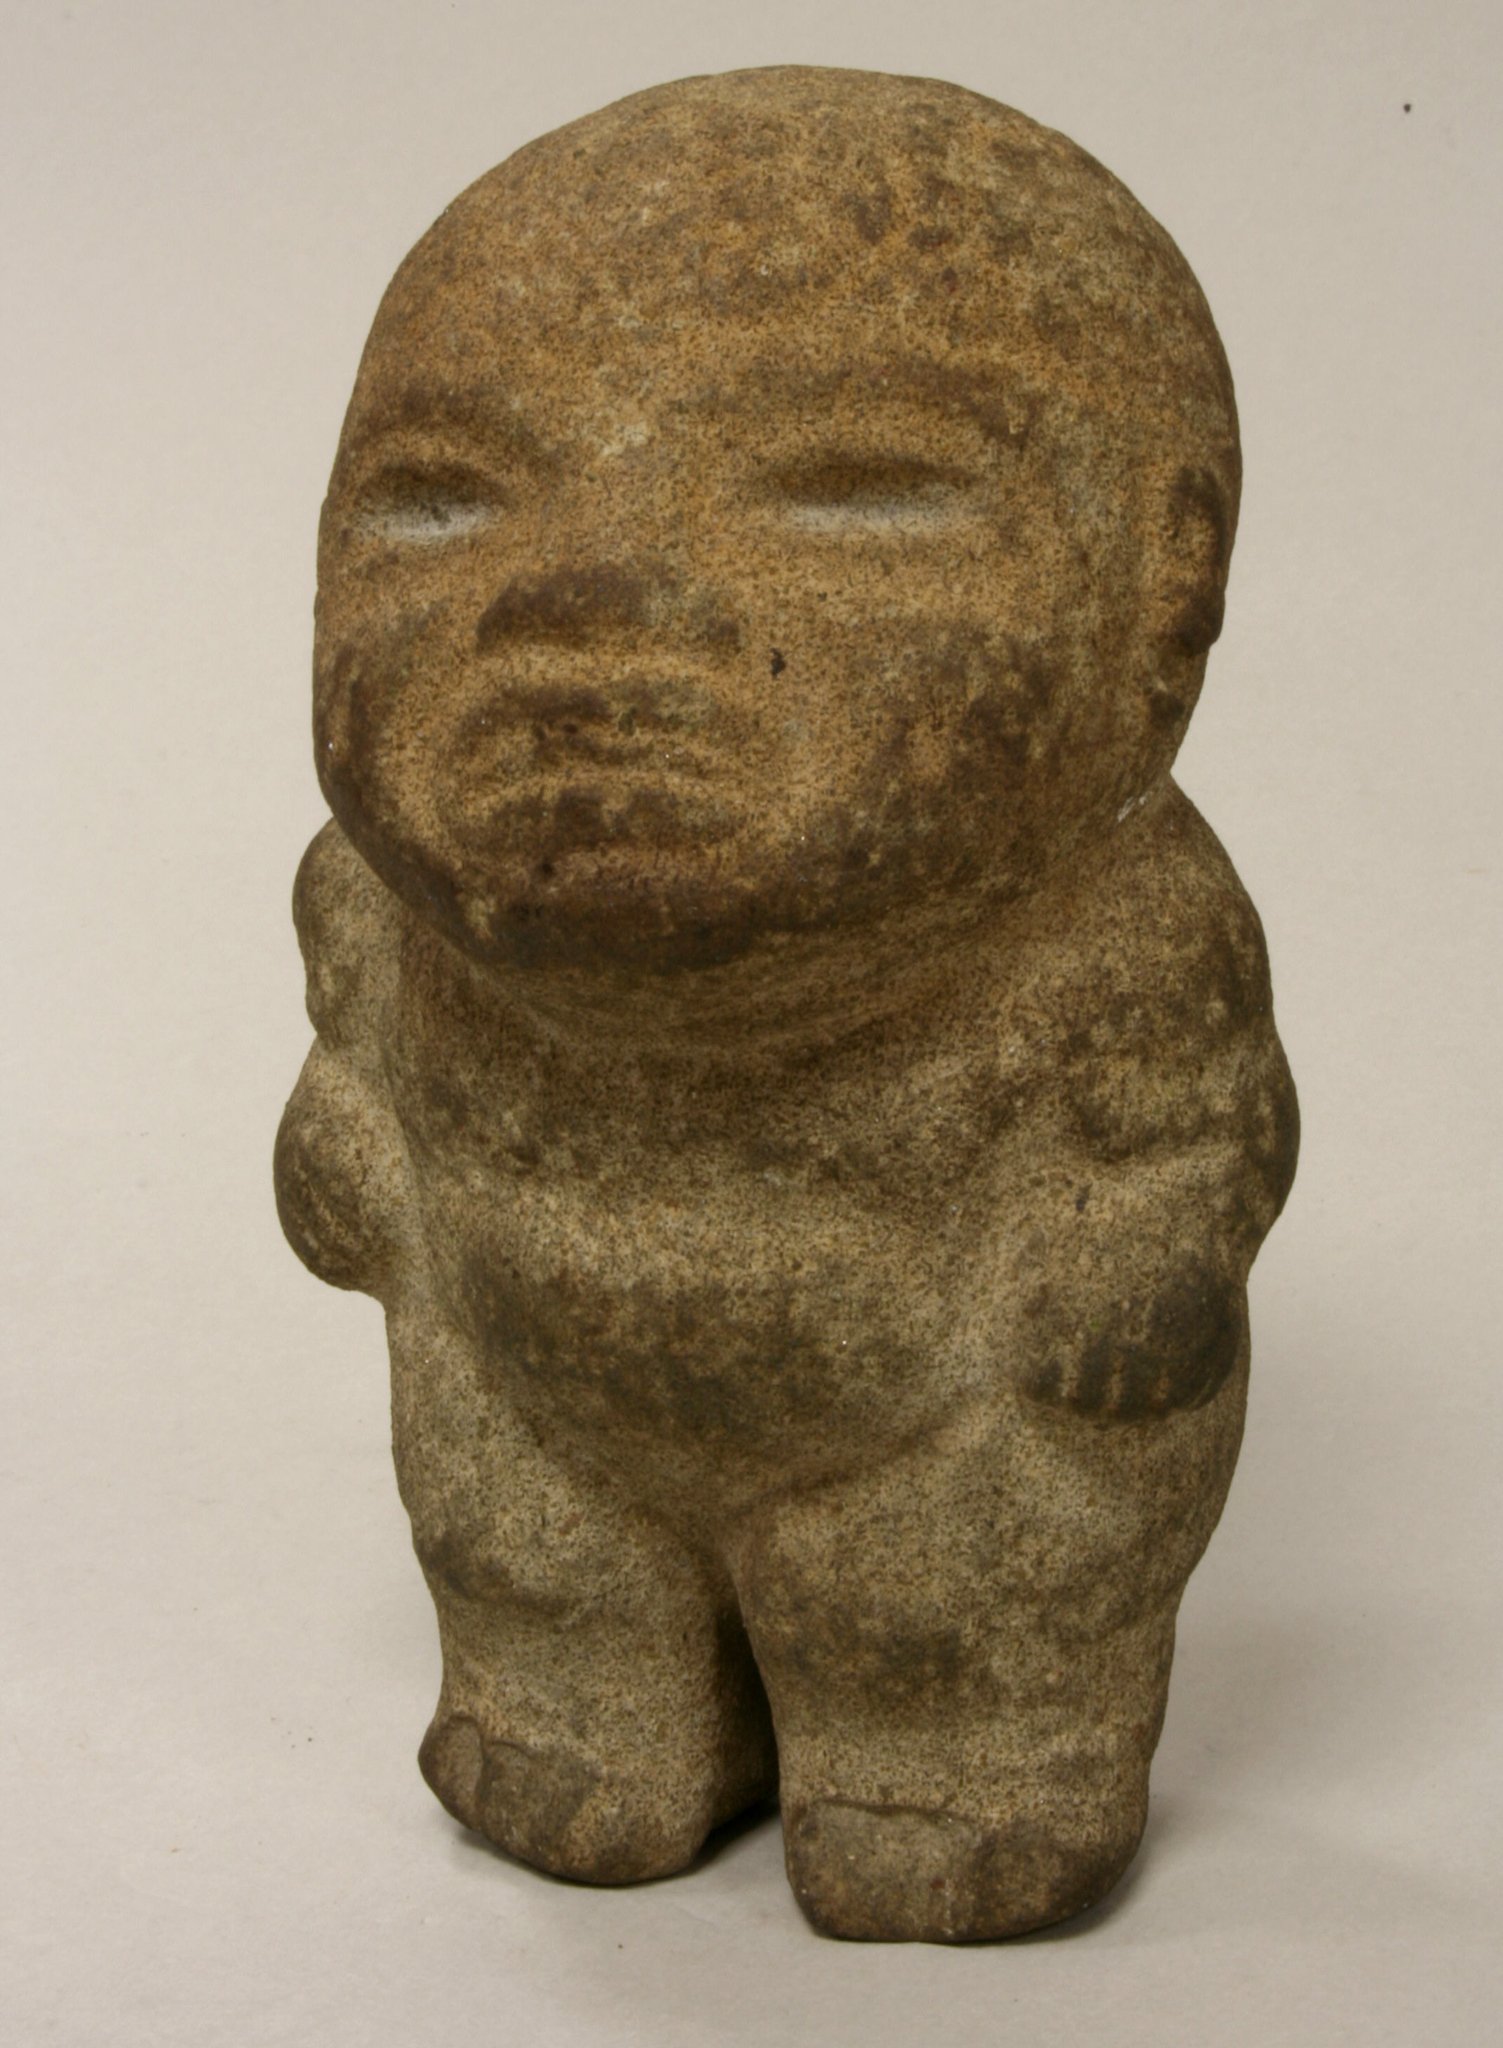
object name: figure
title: Standing Figure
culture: olmec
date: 1000-401 BCE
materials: stone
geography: mexico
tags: human figures